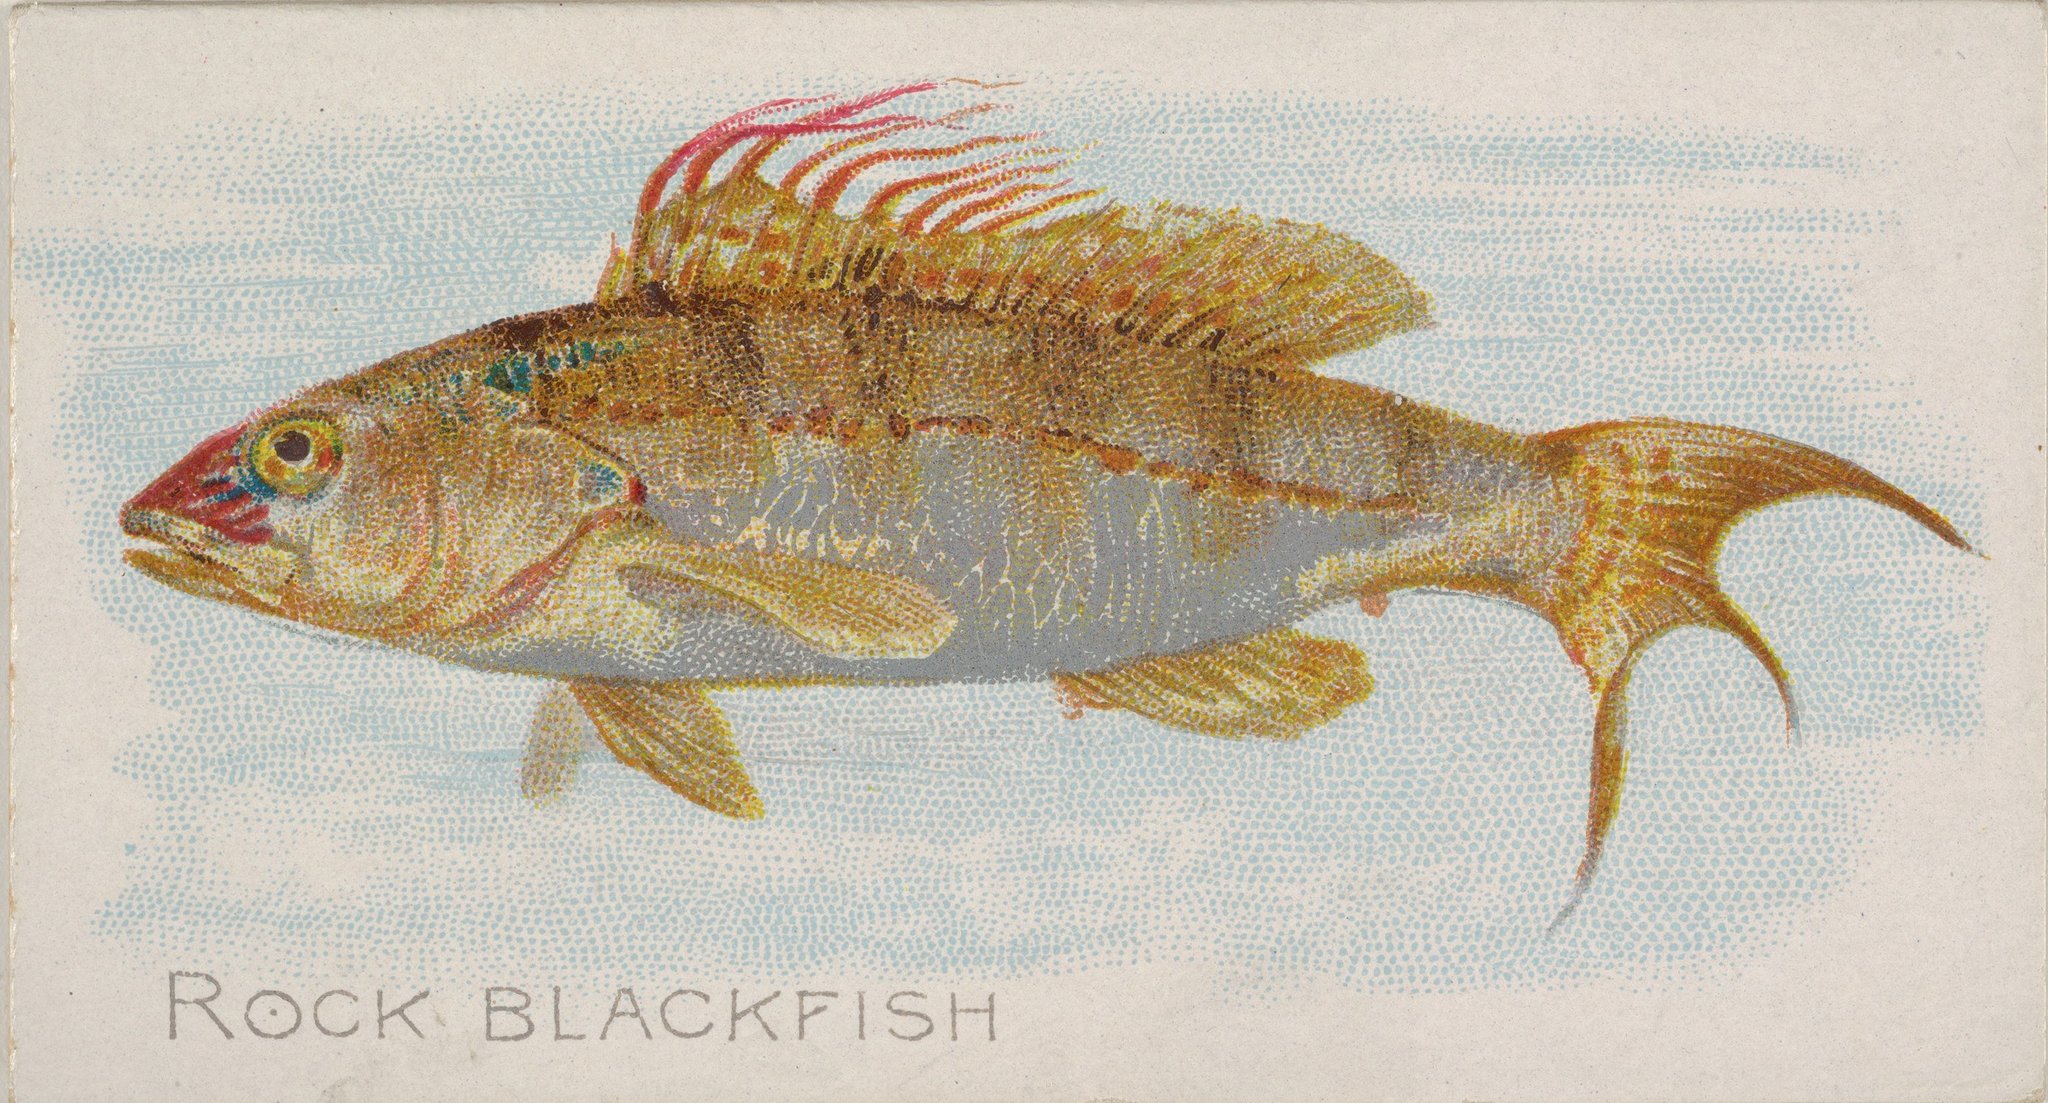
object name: print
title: Rock Blackfish, from the Fish from American Waters series (N8) for Allen & Ginter Cigarettes Brands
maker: allen & ginter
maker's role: publisher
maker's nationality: american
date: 1889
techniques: color lithograph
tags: fish